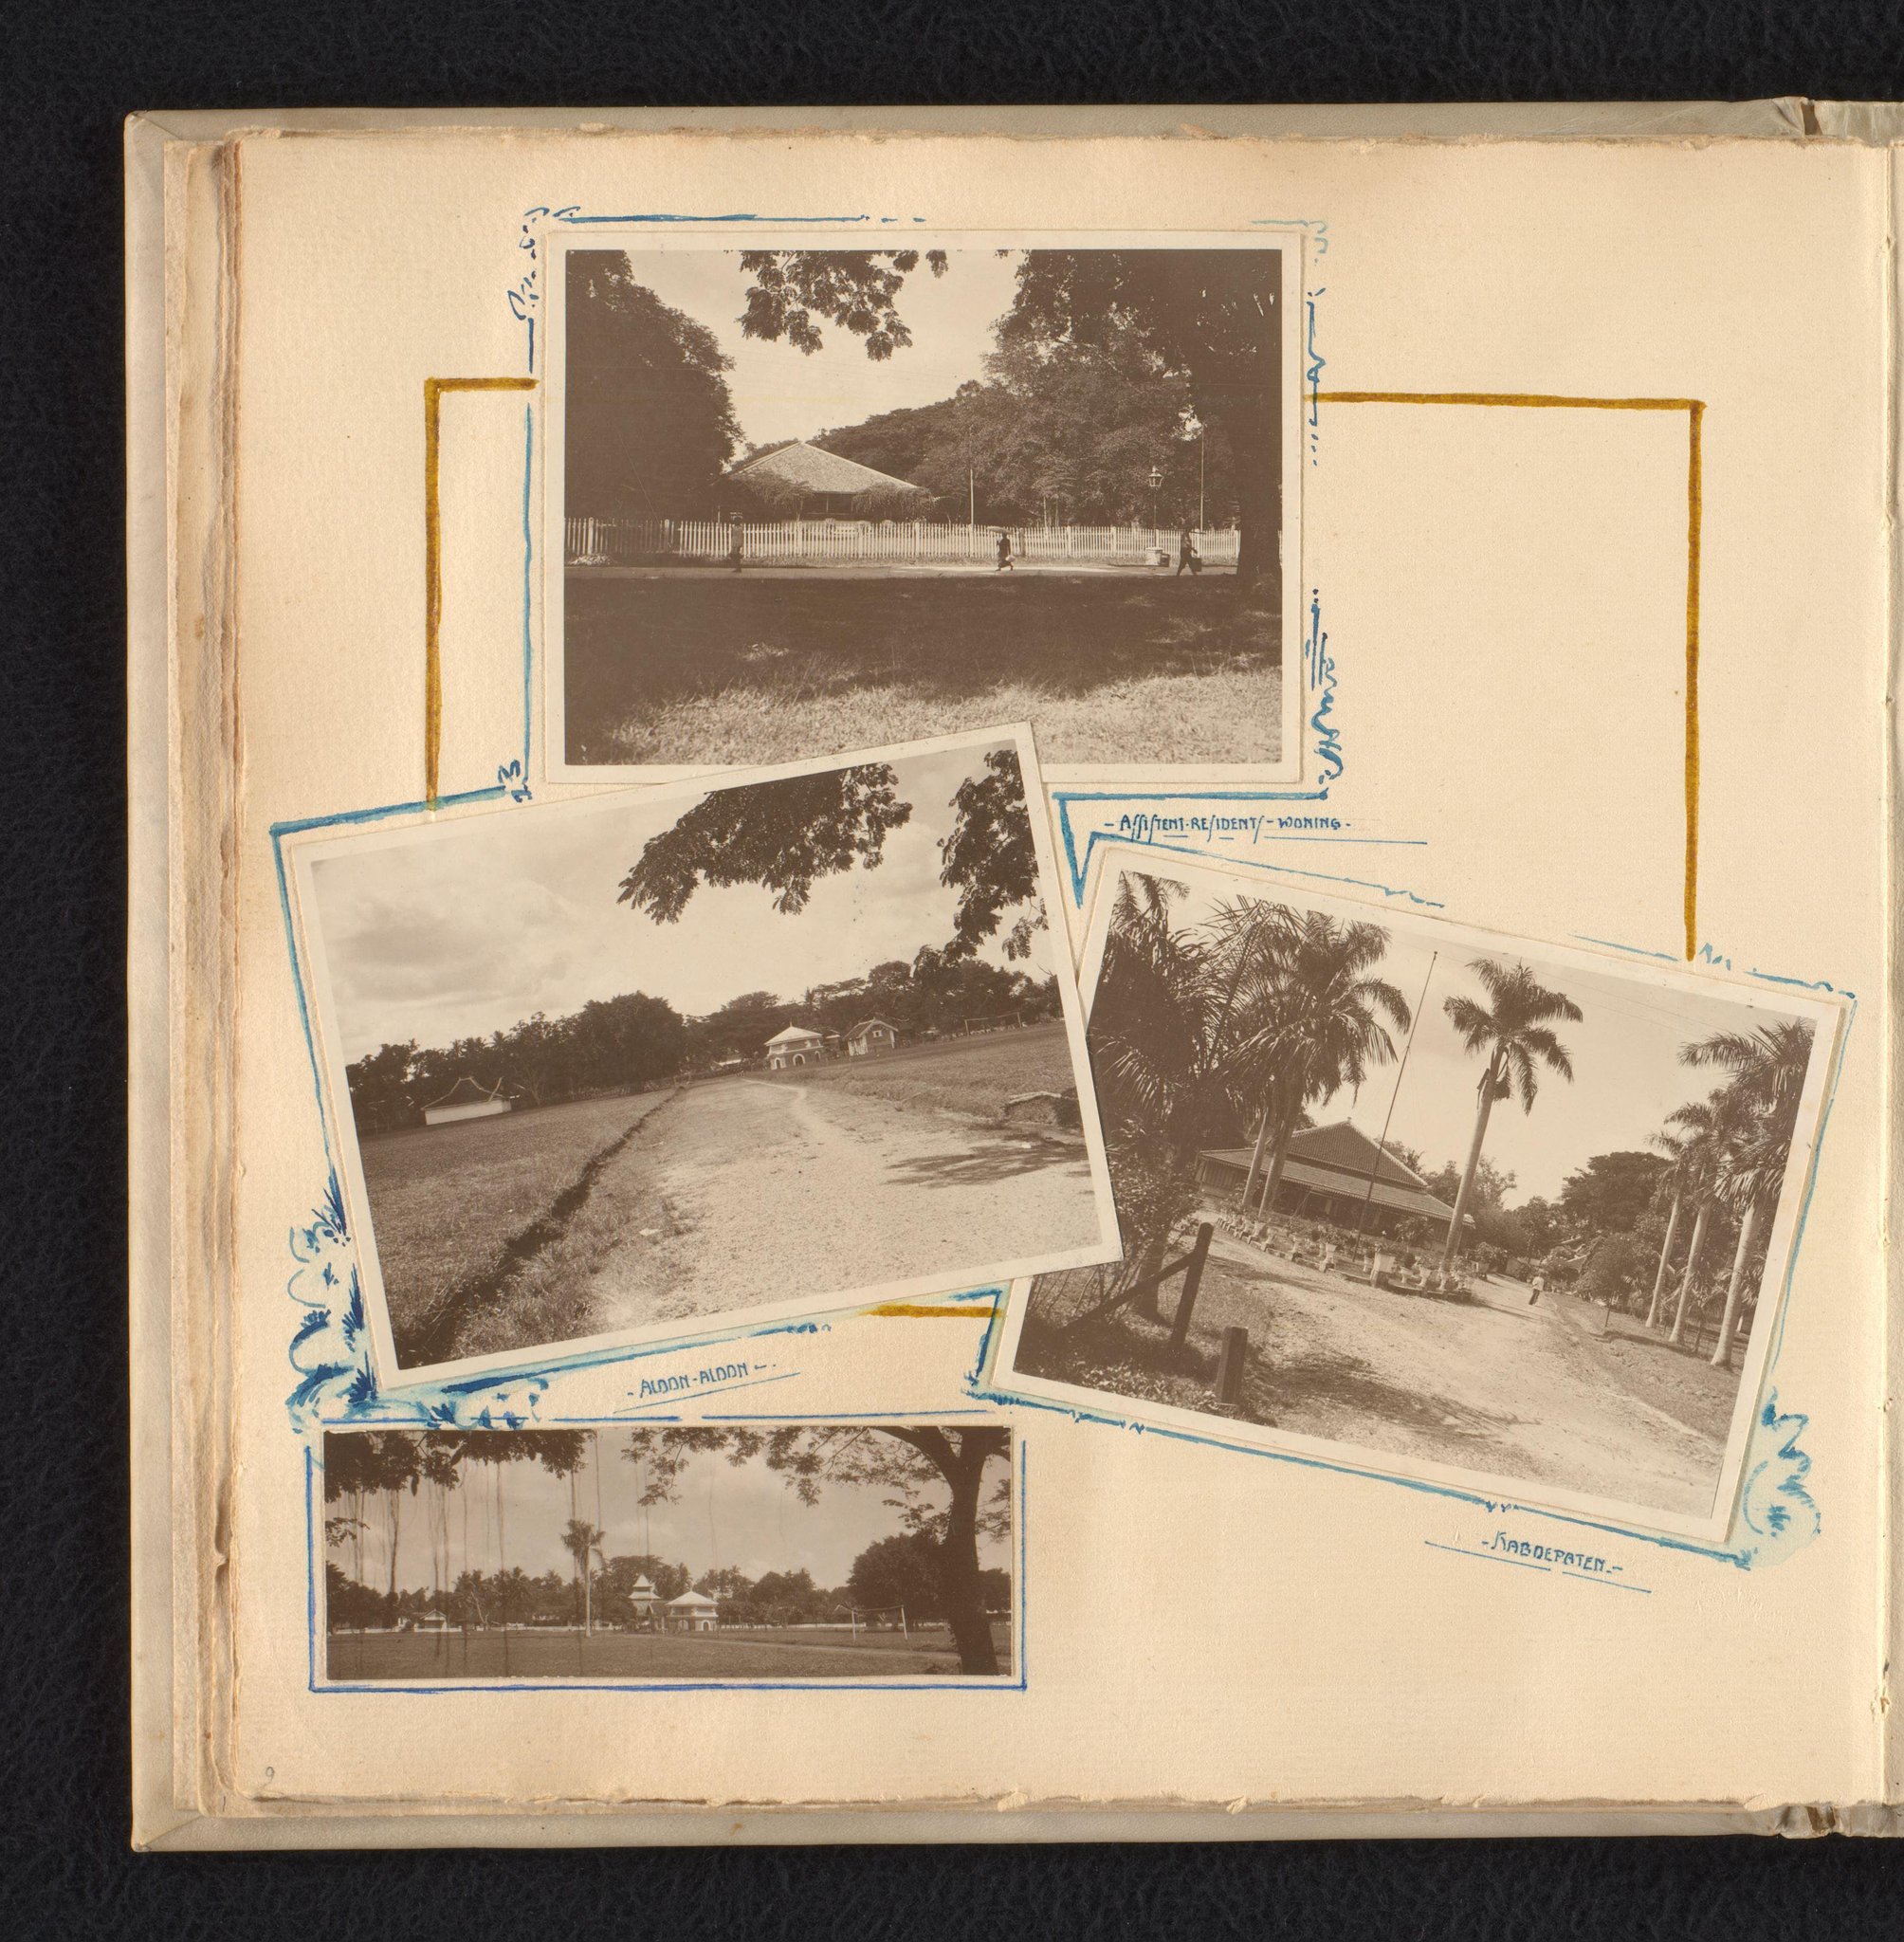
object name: photograph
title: Woningen en andere gebouwen te Grobogan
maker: Anonymous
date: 1910-1928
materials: paper, photographic support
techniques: drawing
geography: grobogan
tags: villa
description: Albumblad met vier foto's van de woning van de assistent-resident en andere gebouwen te Grobogan. Het blad is versierd met randwerk om de foto's. Onderdeel van het fotoalbum aangeboden aan J. Habbema door het Binnenlandsch Bestuur Corps van het Regentschap Grobogan, bij het beëindigen van zijn bestuur over het Regentschap, waarschijnlijk in 1928.